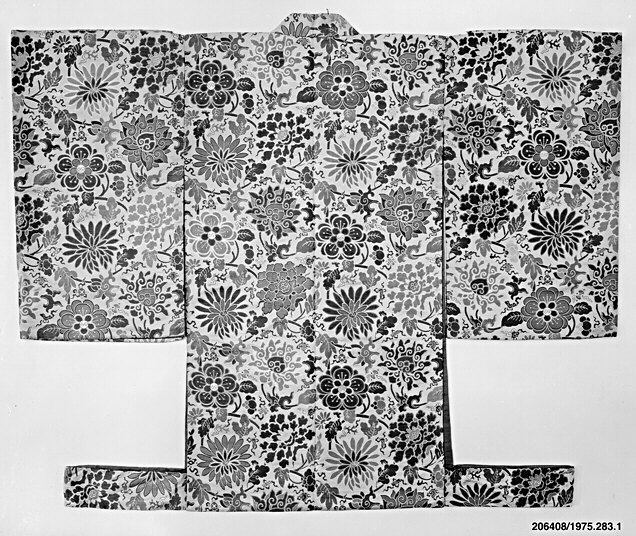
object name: robe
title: Noh Robe (Happi) with Pattern of Flowers and Auspicious Symbols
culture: japanese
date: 1801-1900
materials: metal thread, silk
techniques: patterning